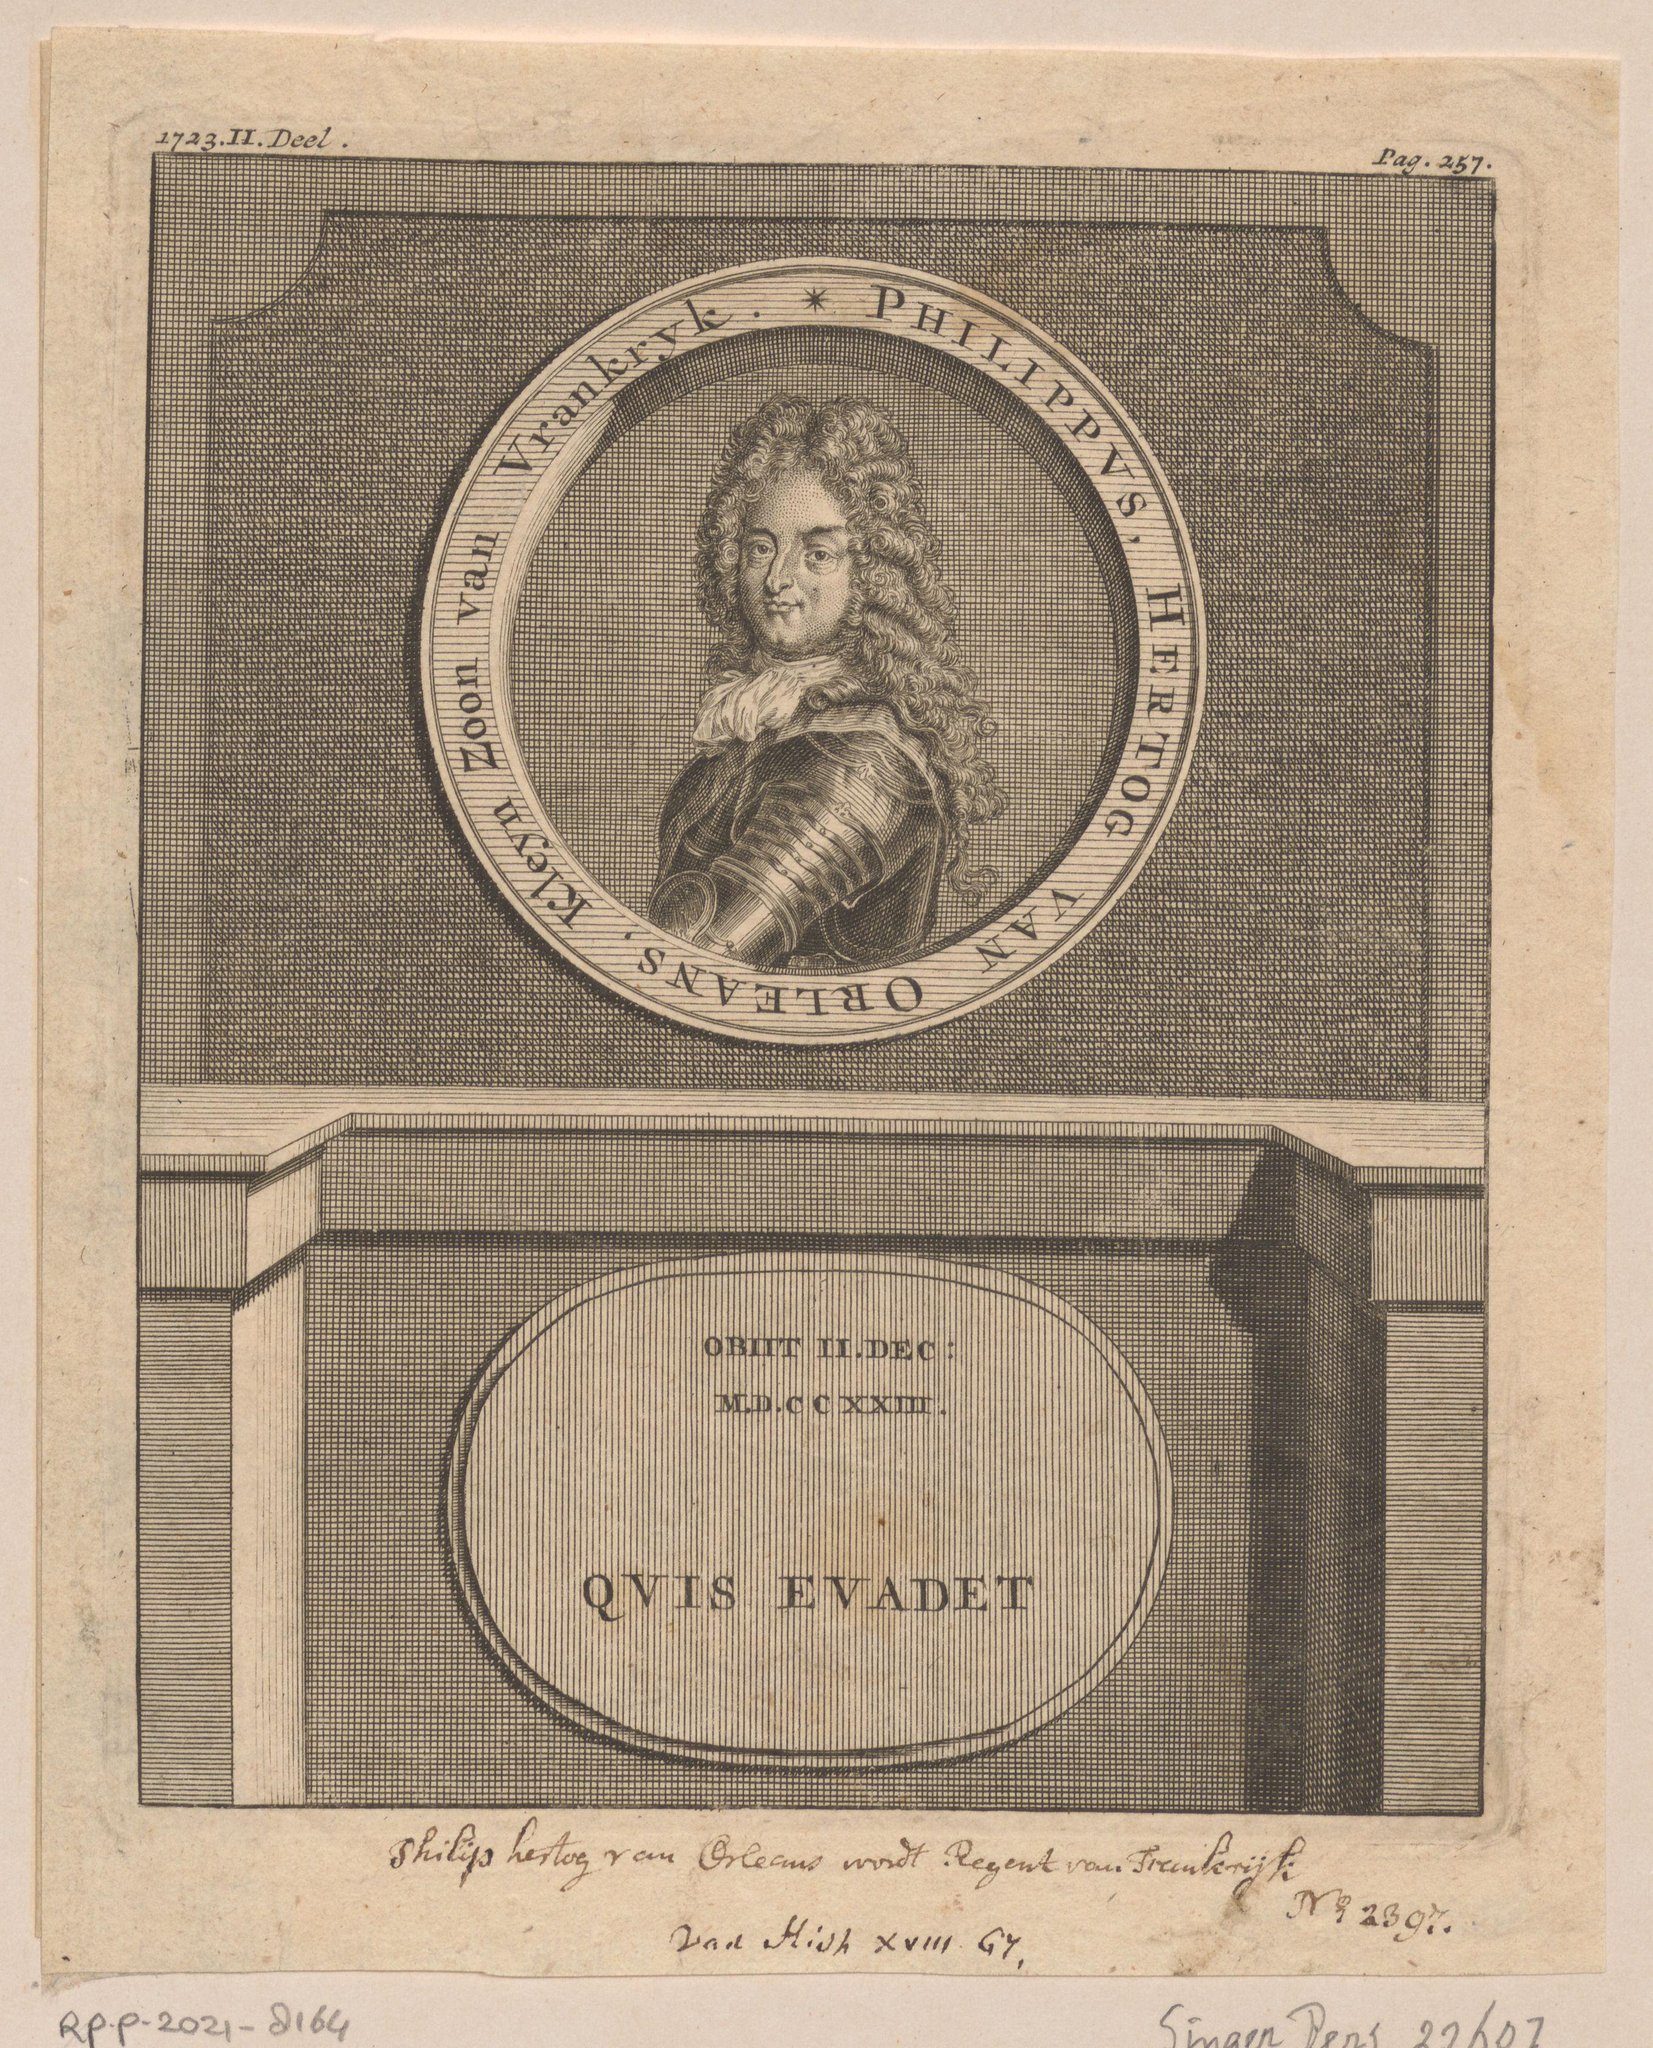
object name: print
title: Portret van Filips II, hertog van Orléans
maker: Anonymous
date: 1723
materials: paper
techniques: engraving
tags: filips ii (hertog van orléans), armour, adult man, historical persons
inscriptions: inscription: ‘Philips hertog van (...)/ No. 2397/ van Hisch XVIII G7’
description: Linksboven: 1723.II.Deel. Rechtsboven: Pag. 257.